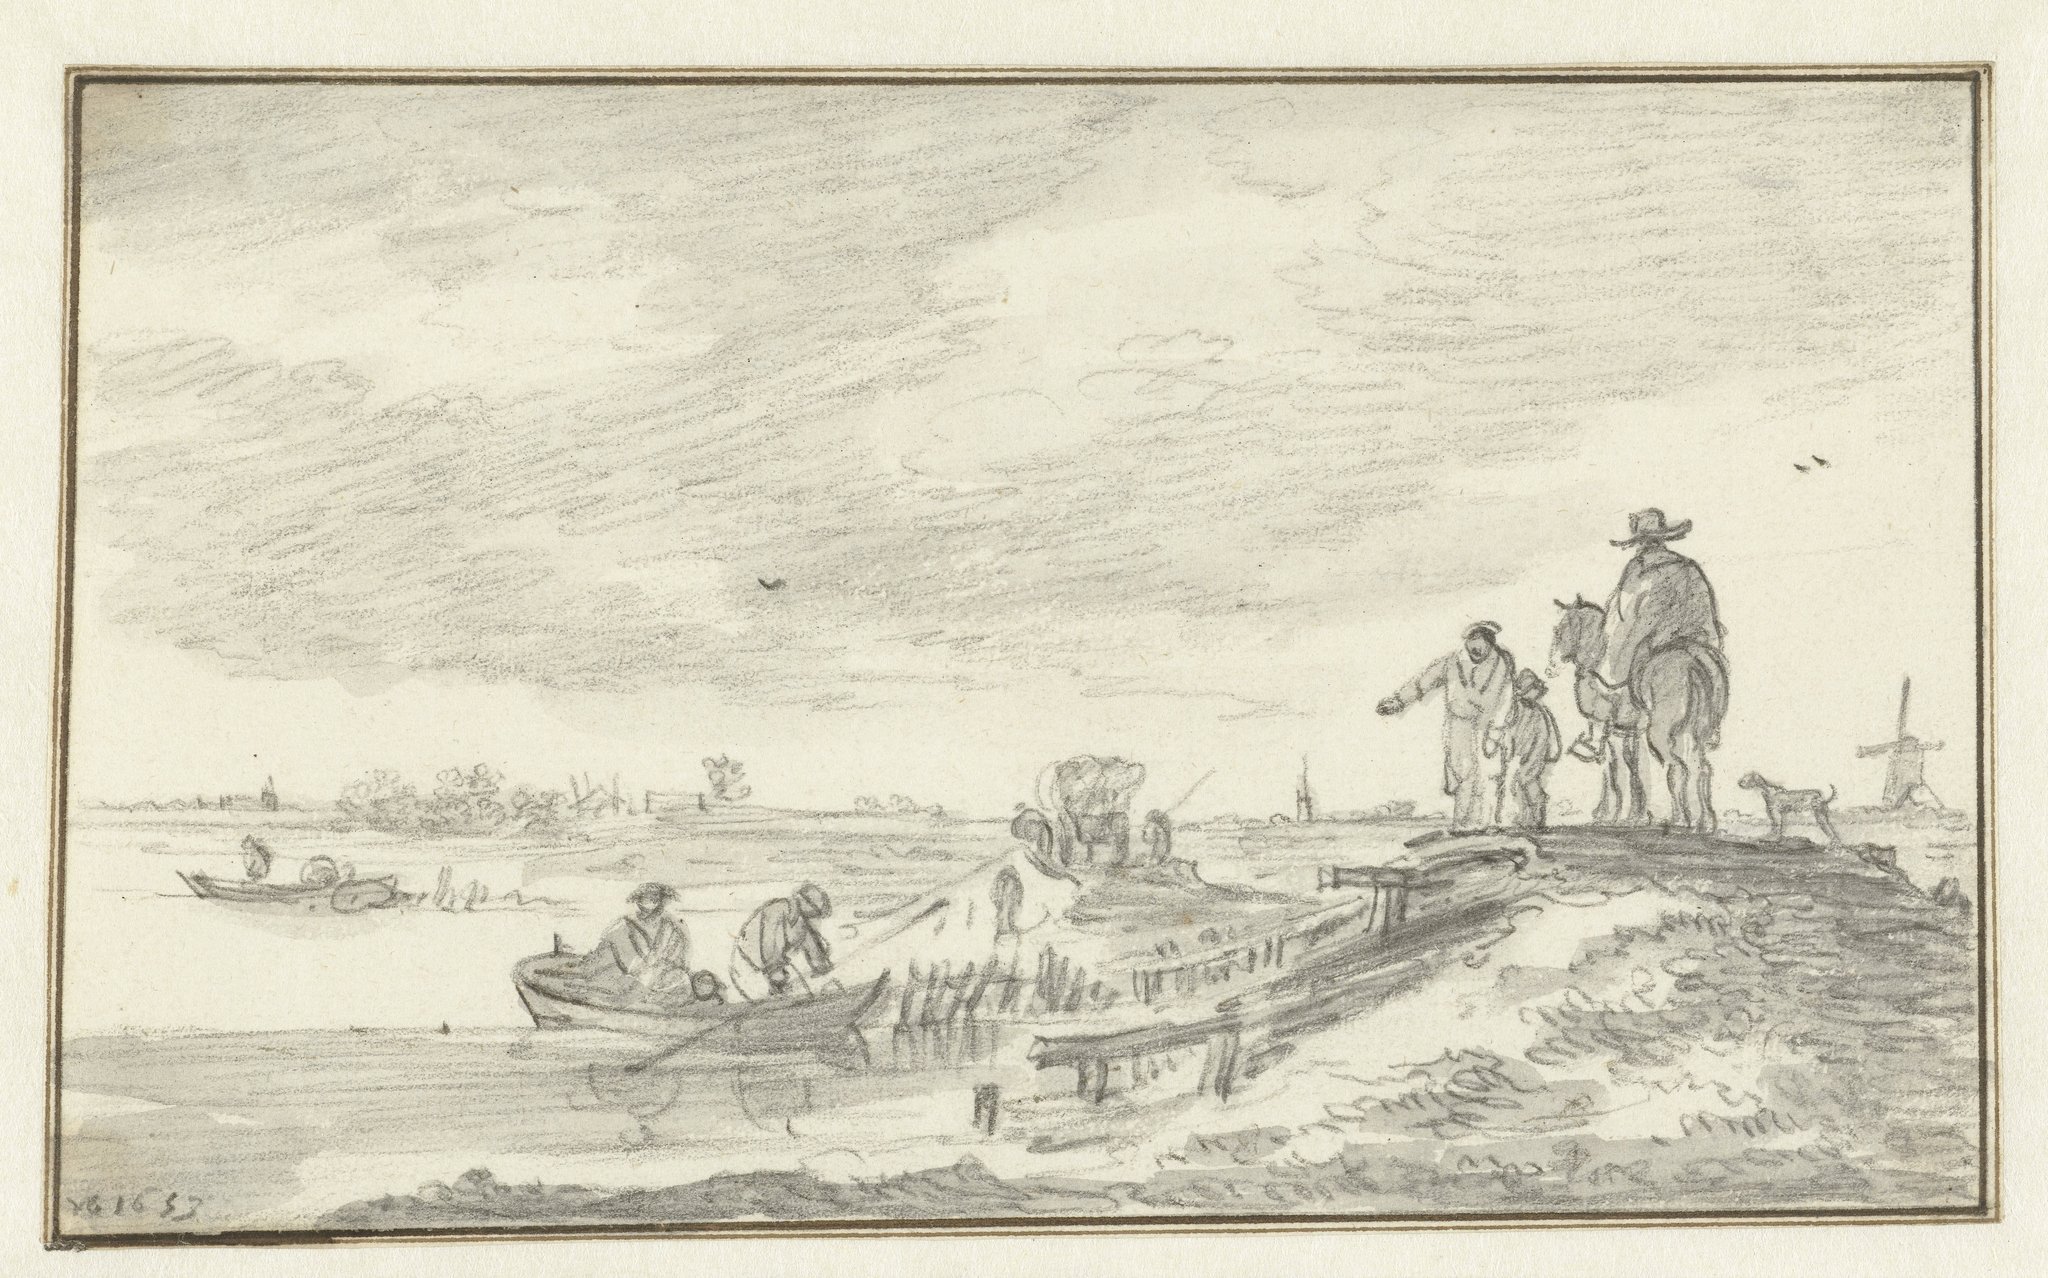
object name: drawing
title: Landweg langs een vaart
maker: jan van goyen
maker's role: draughtsman, painter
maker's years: 1596-1656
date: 1653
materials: chalk, paper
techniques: brush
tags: landscapes with waters, waterscapes, seascapes (in the temperate zone)